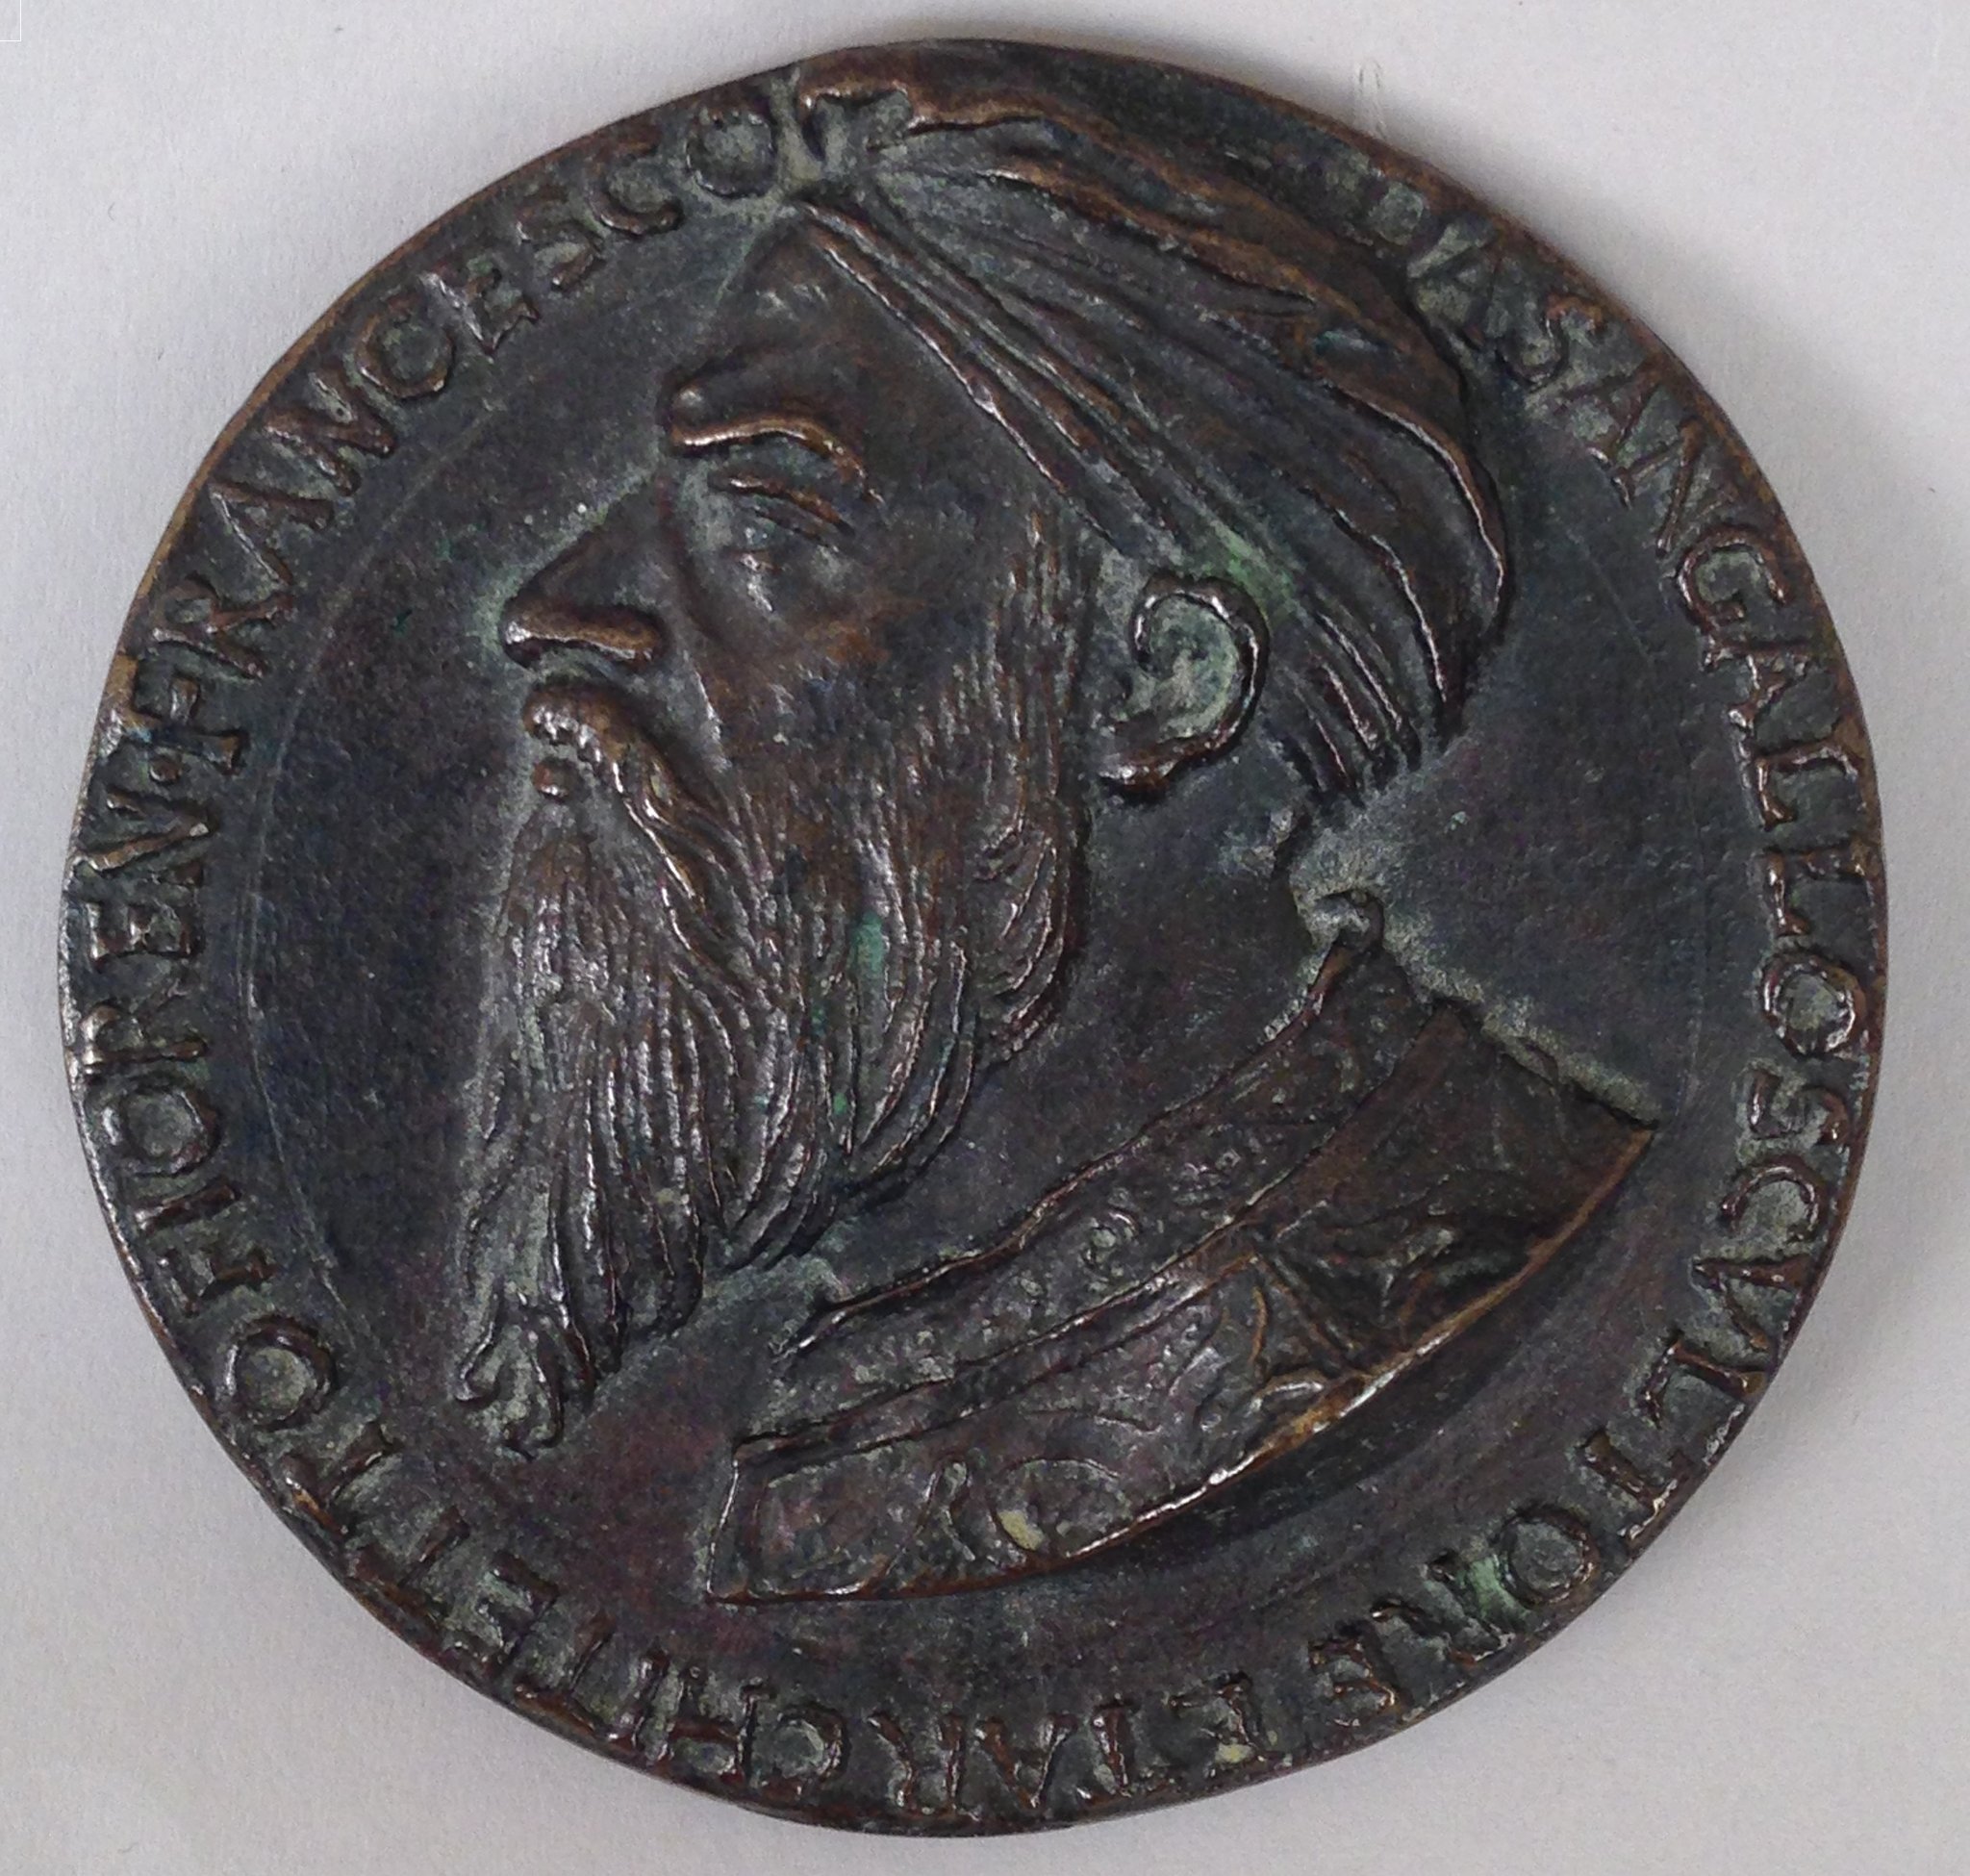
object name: medal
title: Francesco da Sangallo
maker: francesco da sangallo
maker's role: artist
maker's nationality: italian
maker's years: 1494-1576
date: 1551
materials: bronze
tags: men,profiles